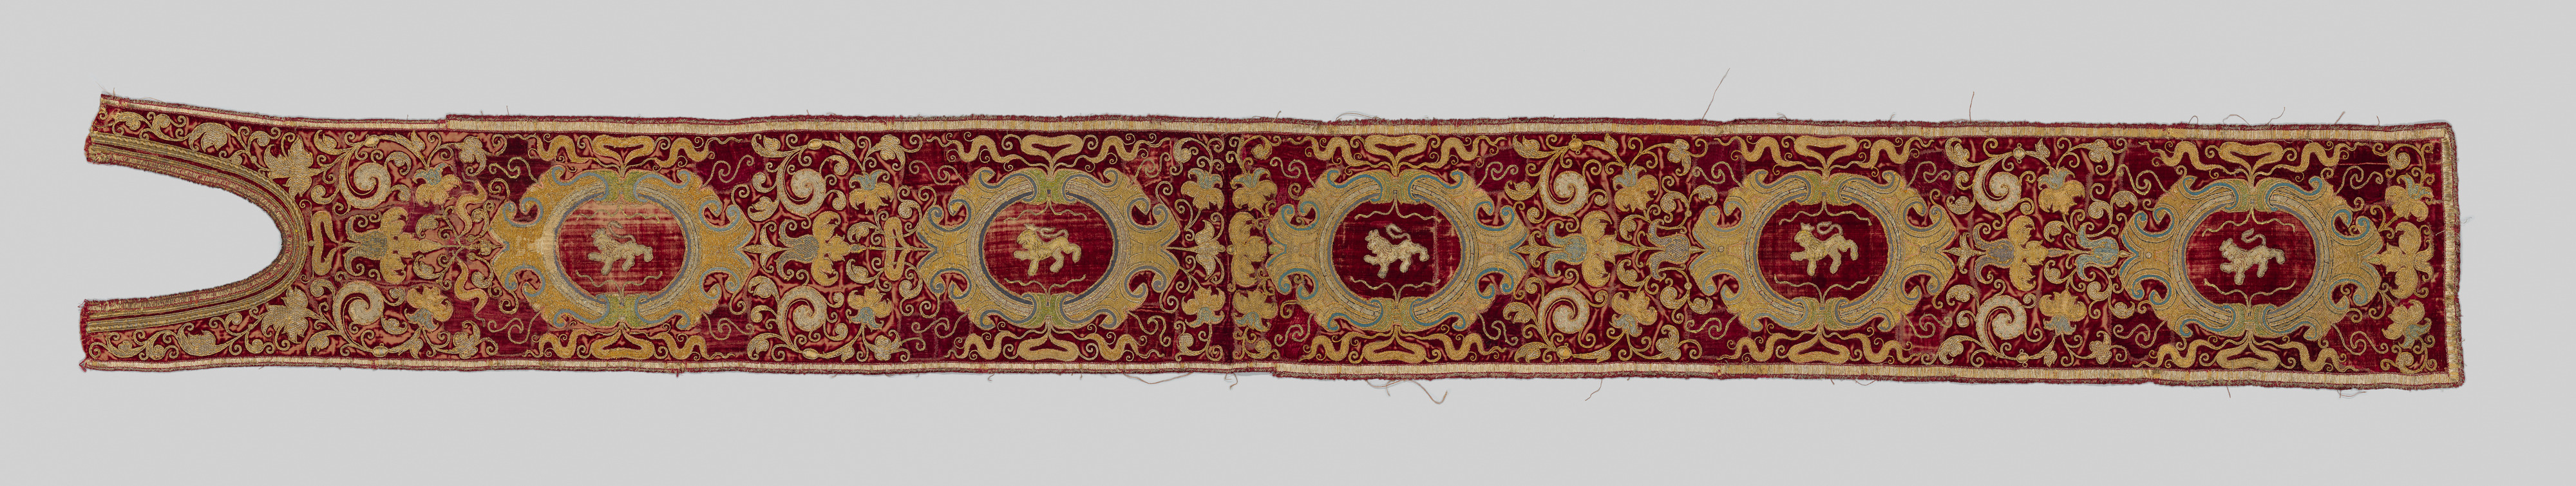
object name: textile cover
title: Two Orphrey Sections made into a Hanging or Cover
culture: spanish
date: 1534-1566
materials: hemp, metal, silk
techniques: weave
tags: lions